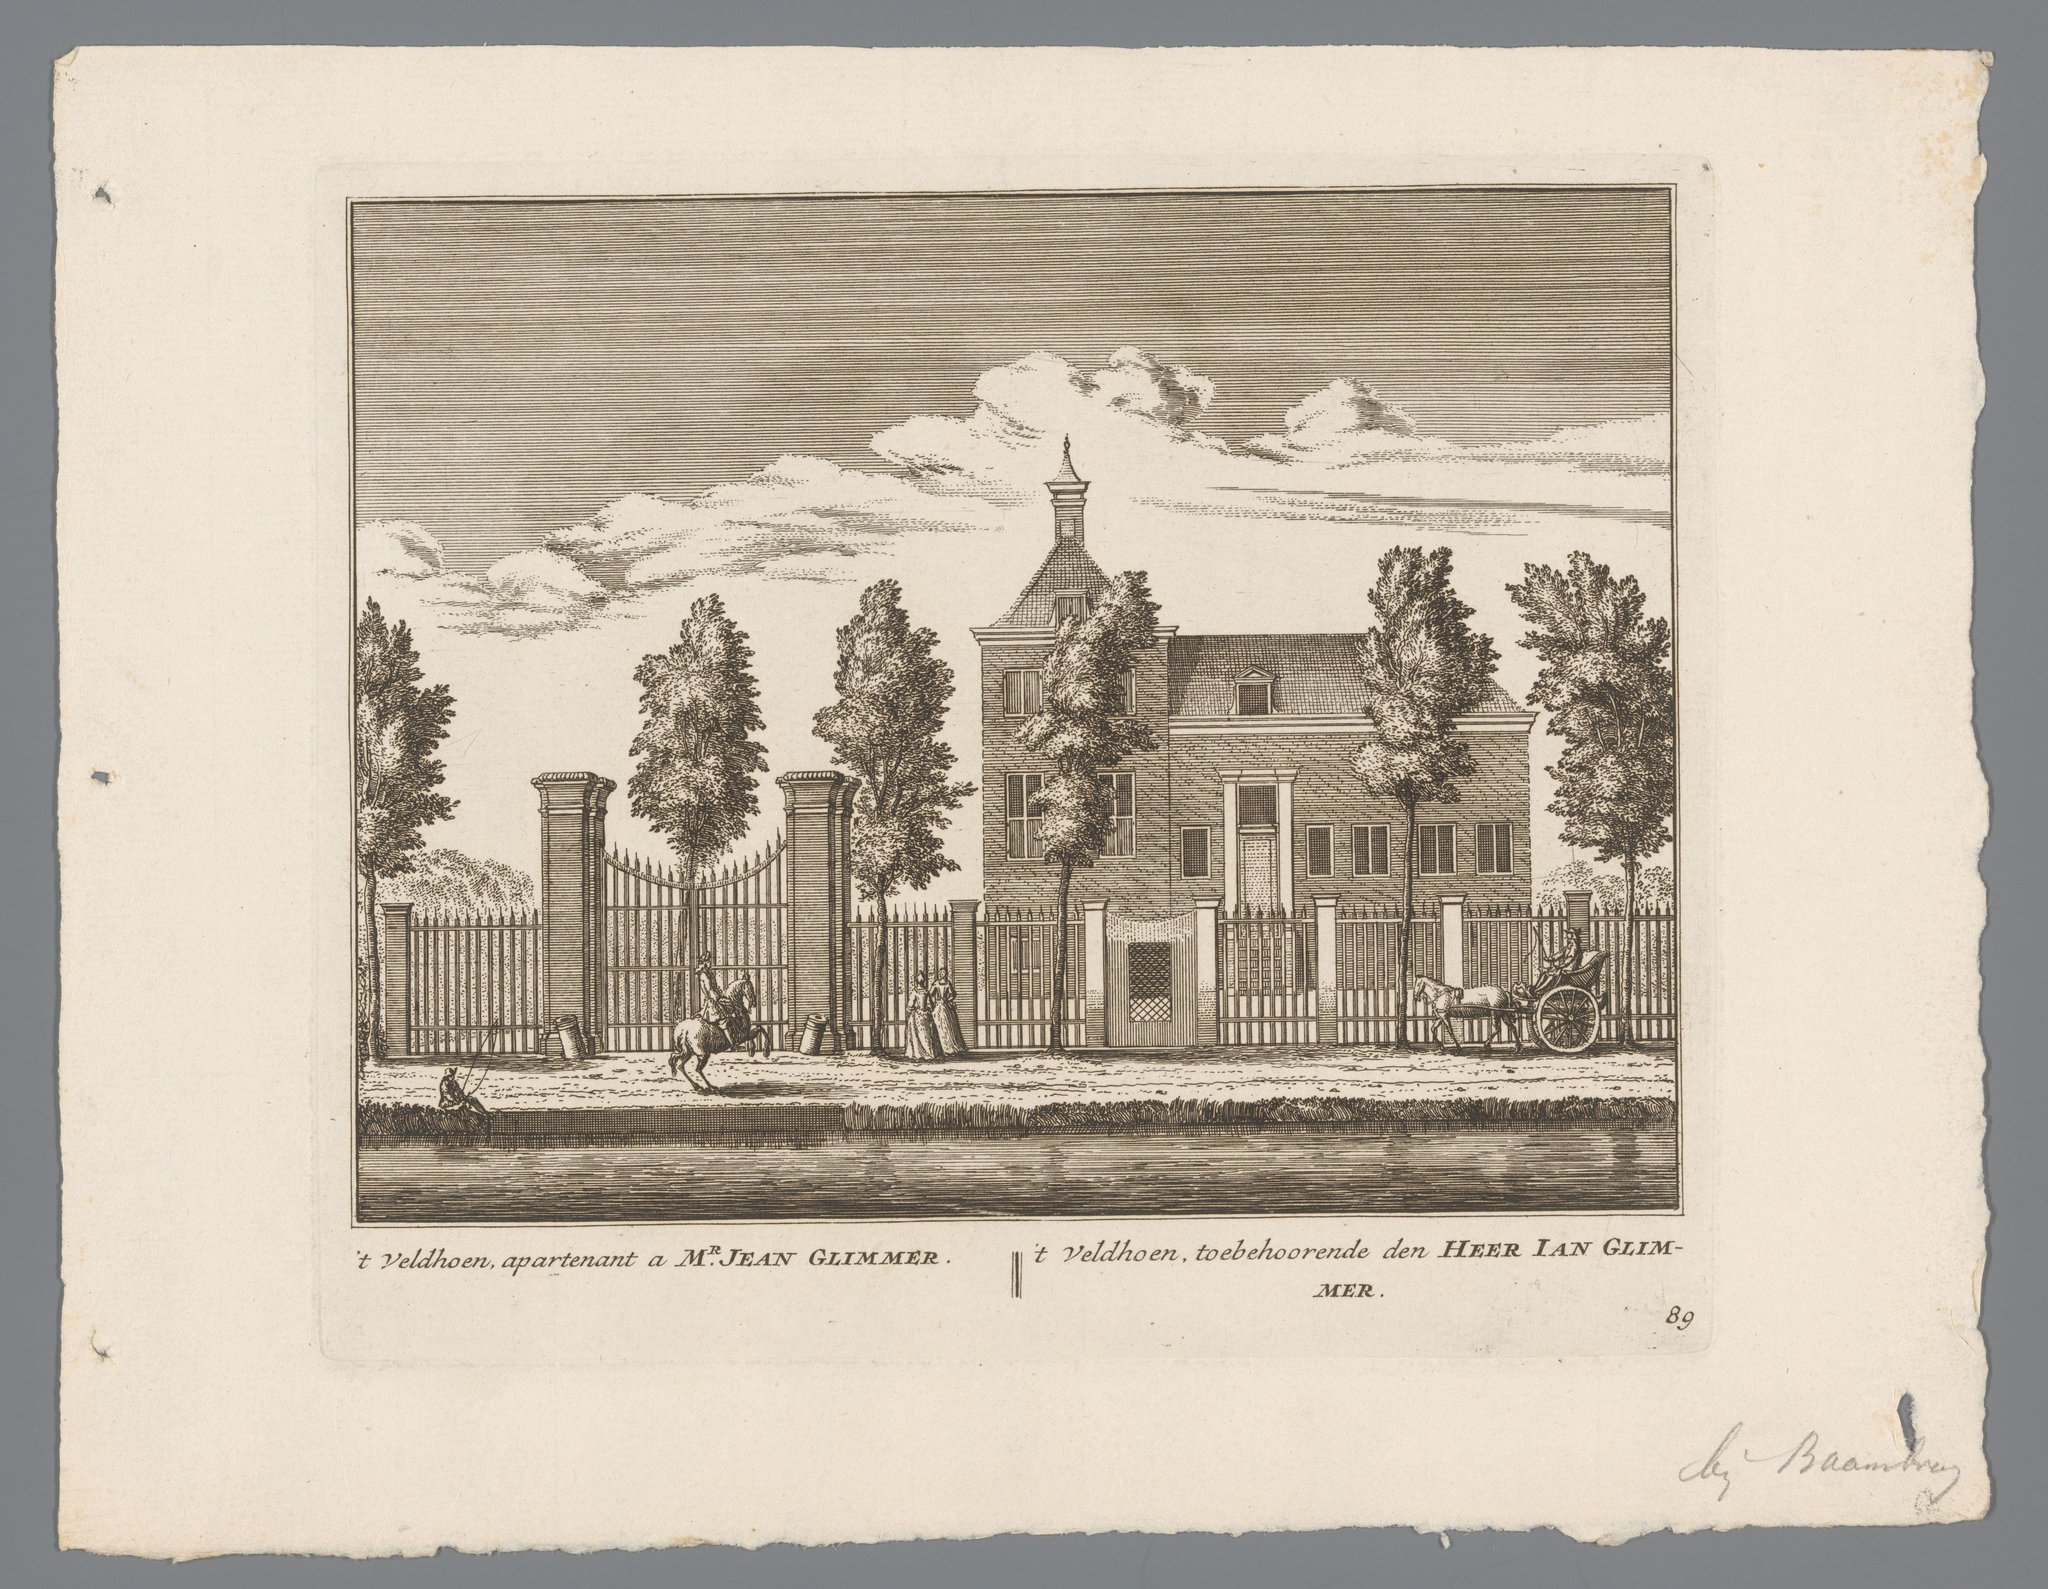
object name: print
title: Gezicht op de buitenplaats 't Veldhoen, bij Baambrugge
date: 1730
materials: paper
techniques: etching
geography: amsterdam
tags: rural housing, e.g. country-house, villa, cottage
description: Prent uit: Rademaker, Abraham. Hollands Arcadia, of de vermaarde rivier den Amstel (...) / L'Arcadie Hollandoise (...). Amsterdam: Leonard Schenk, 1730.